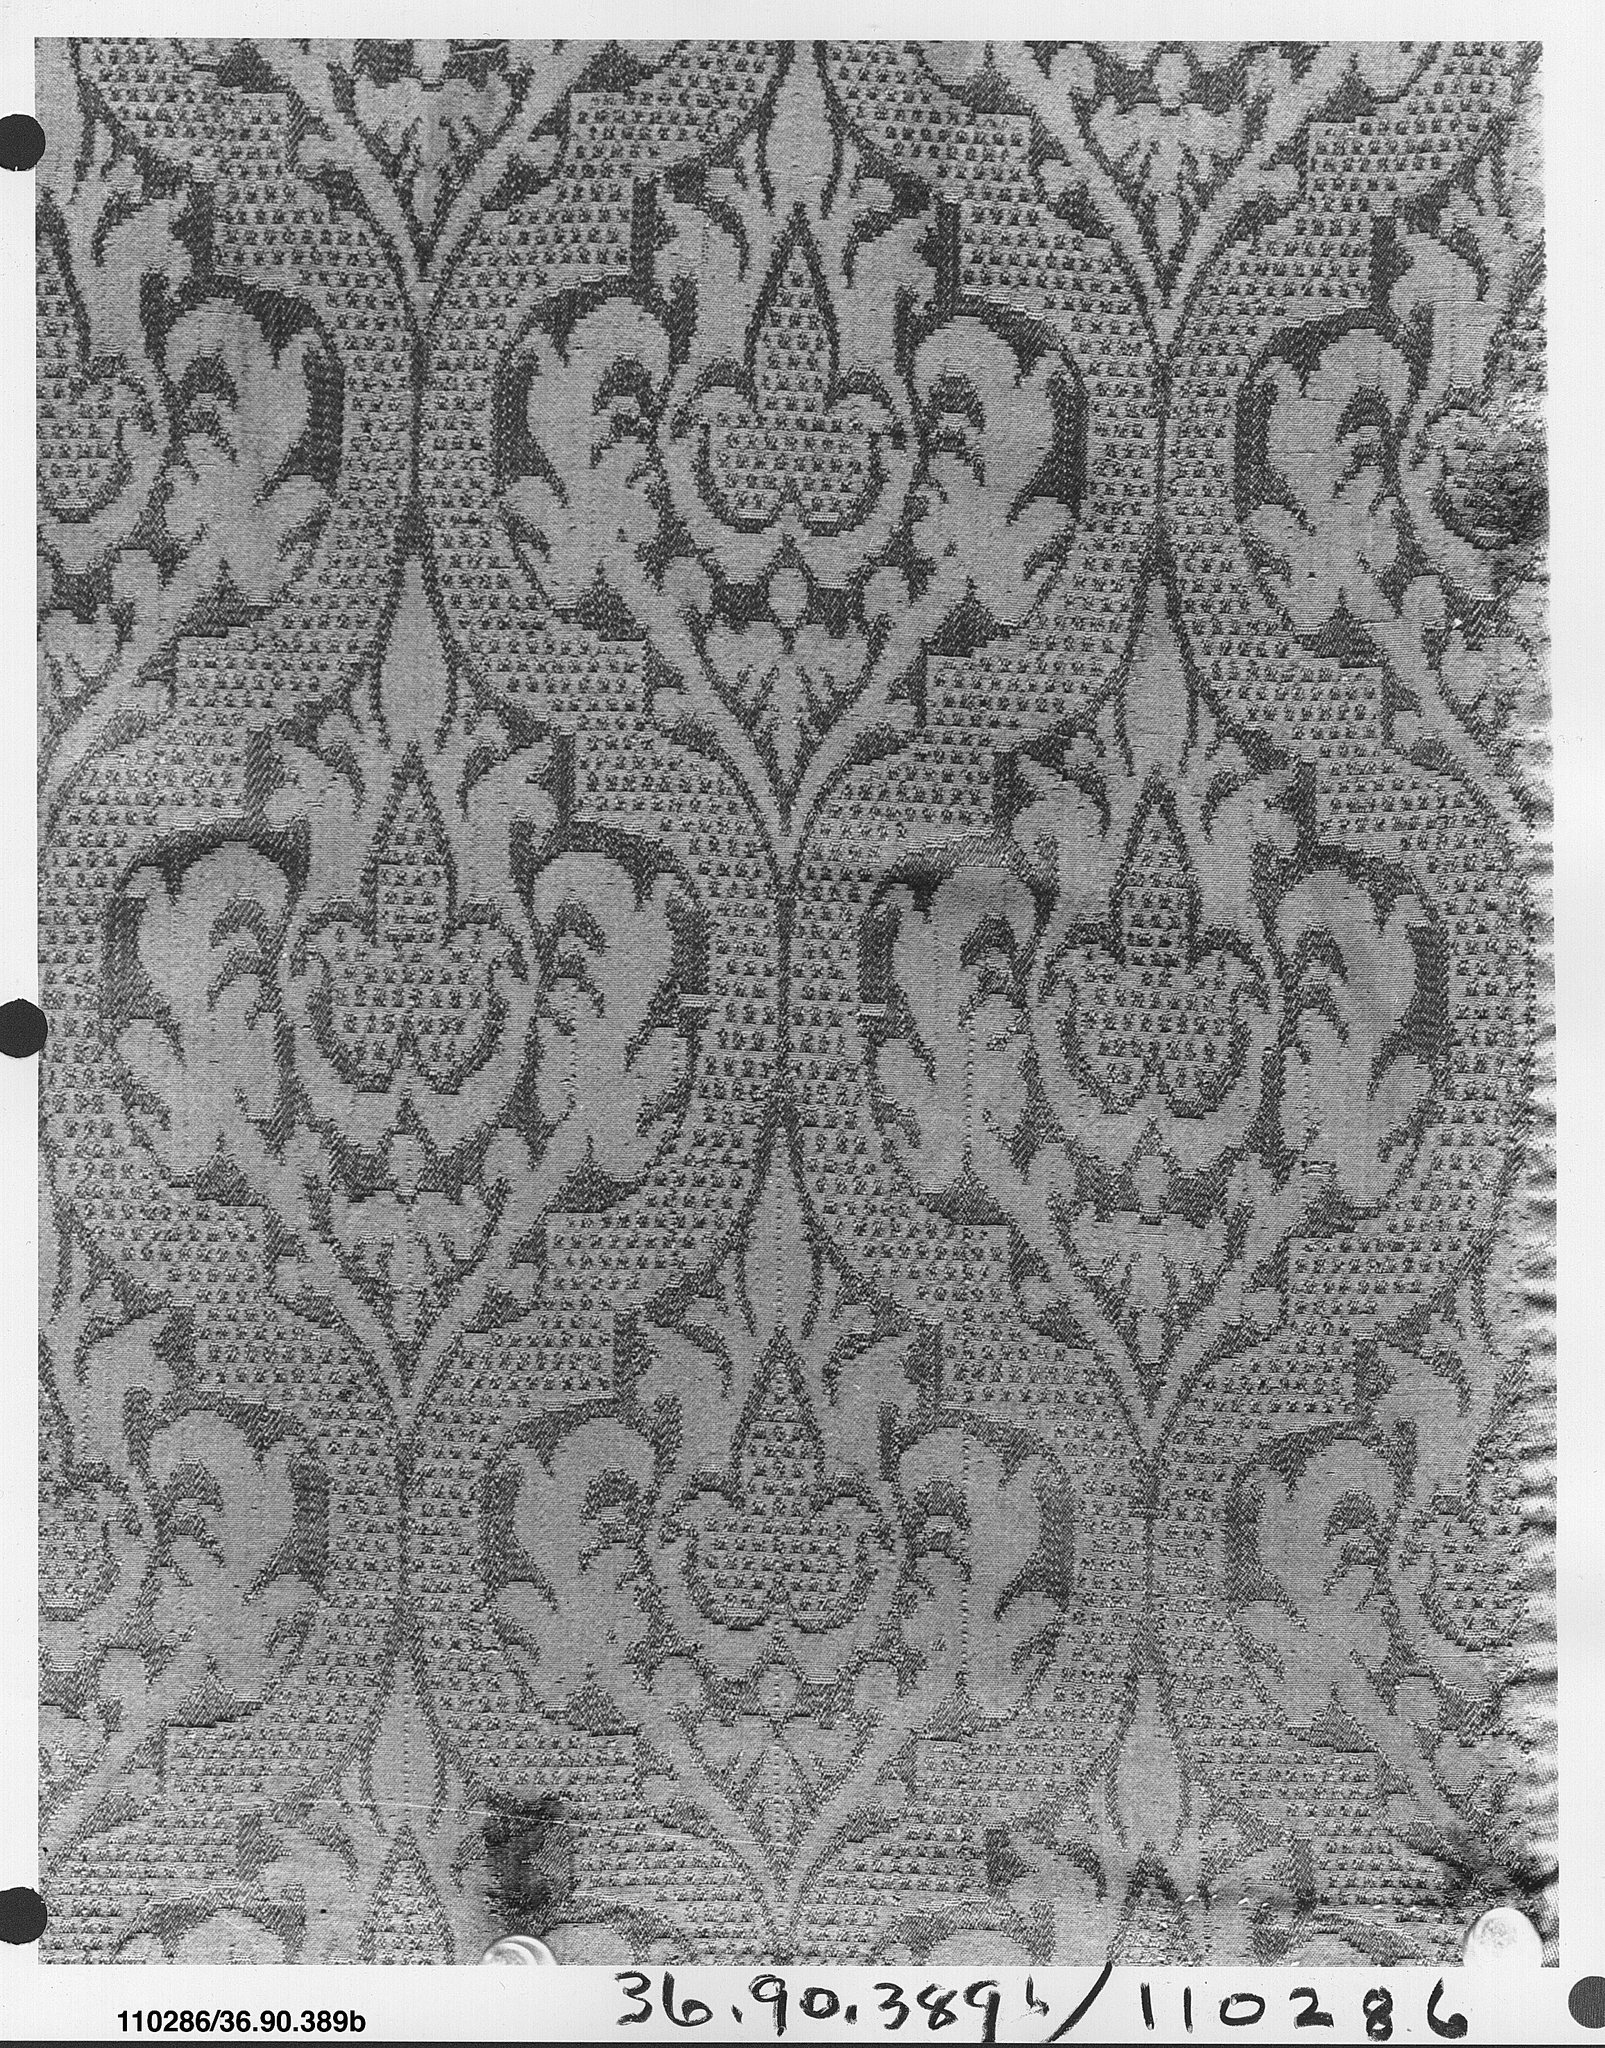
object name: piece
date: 1501-1600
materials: silk